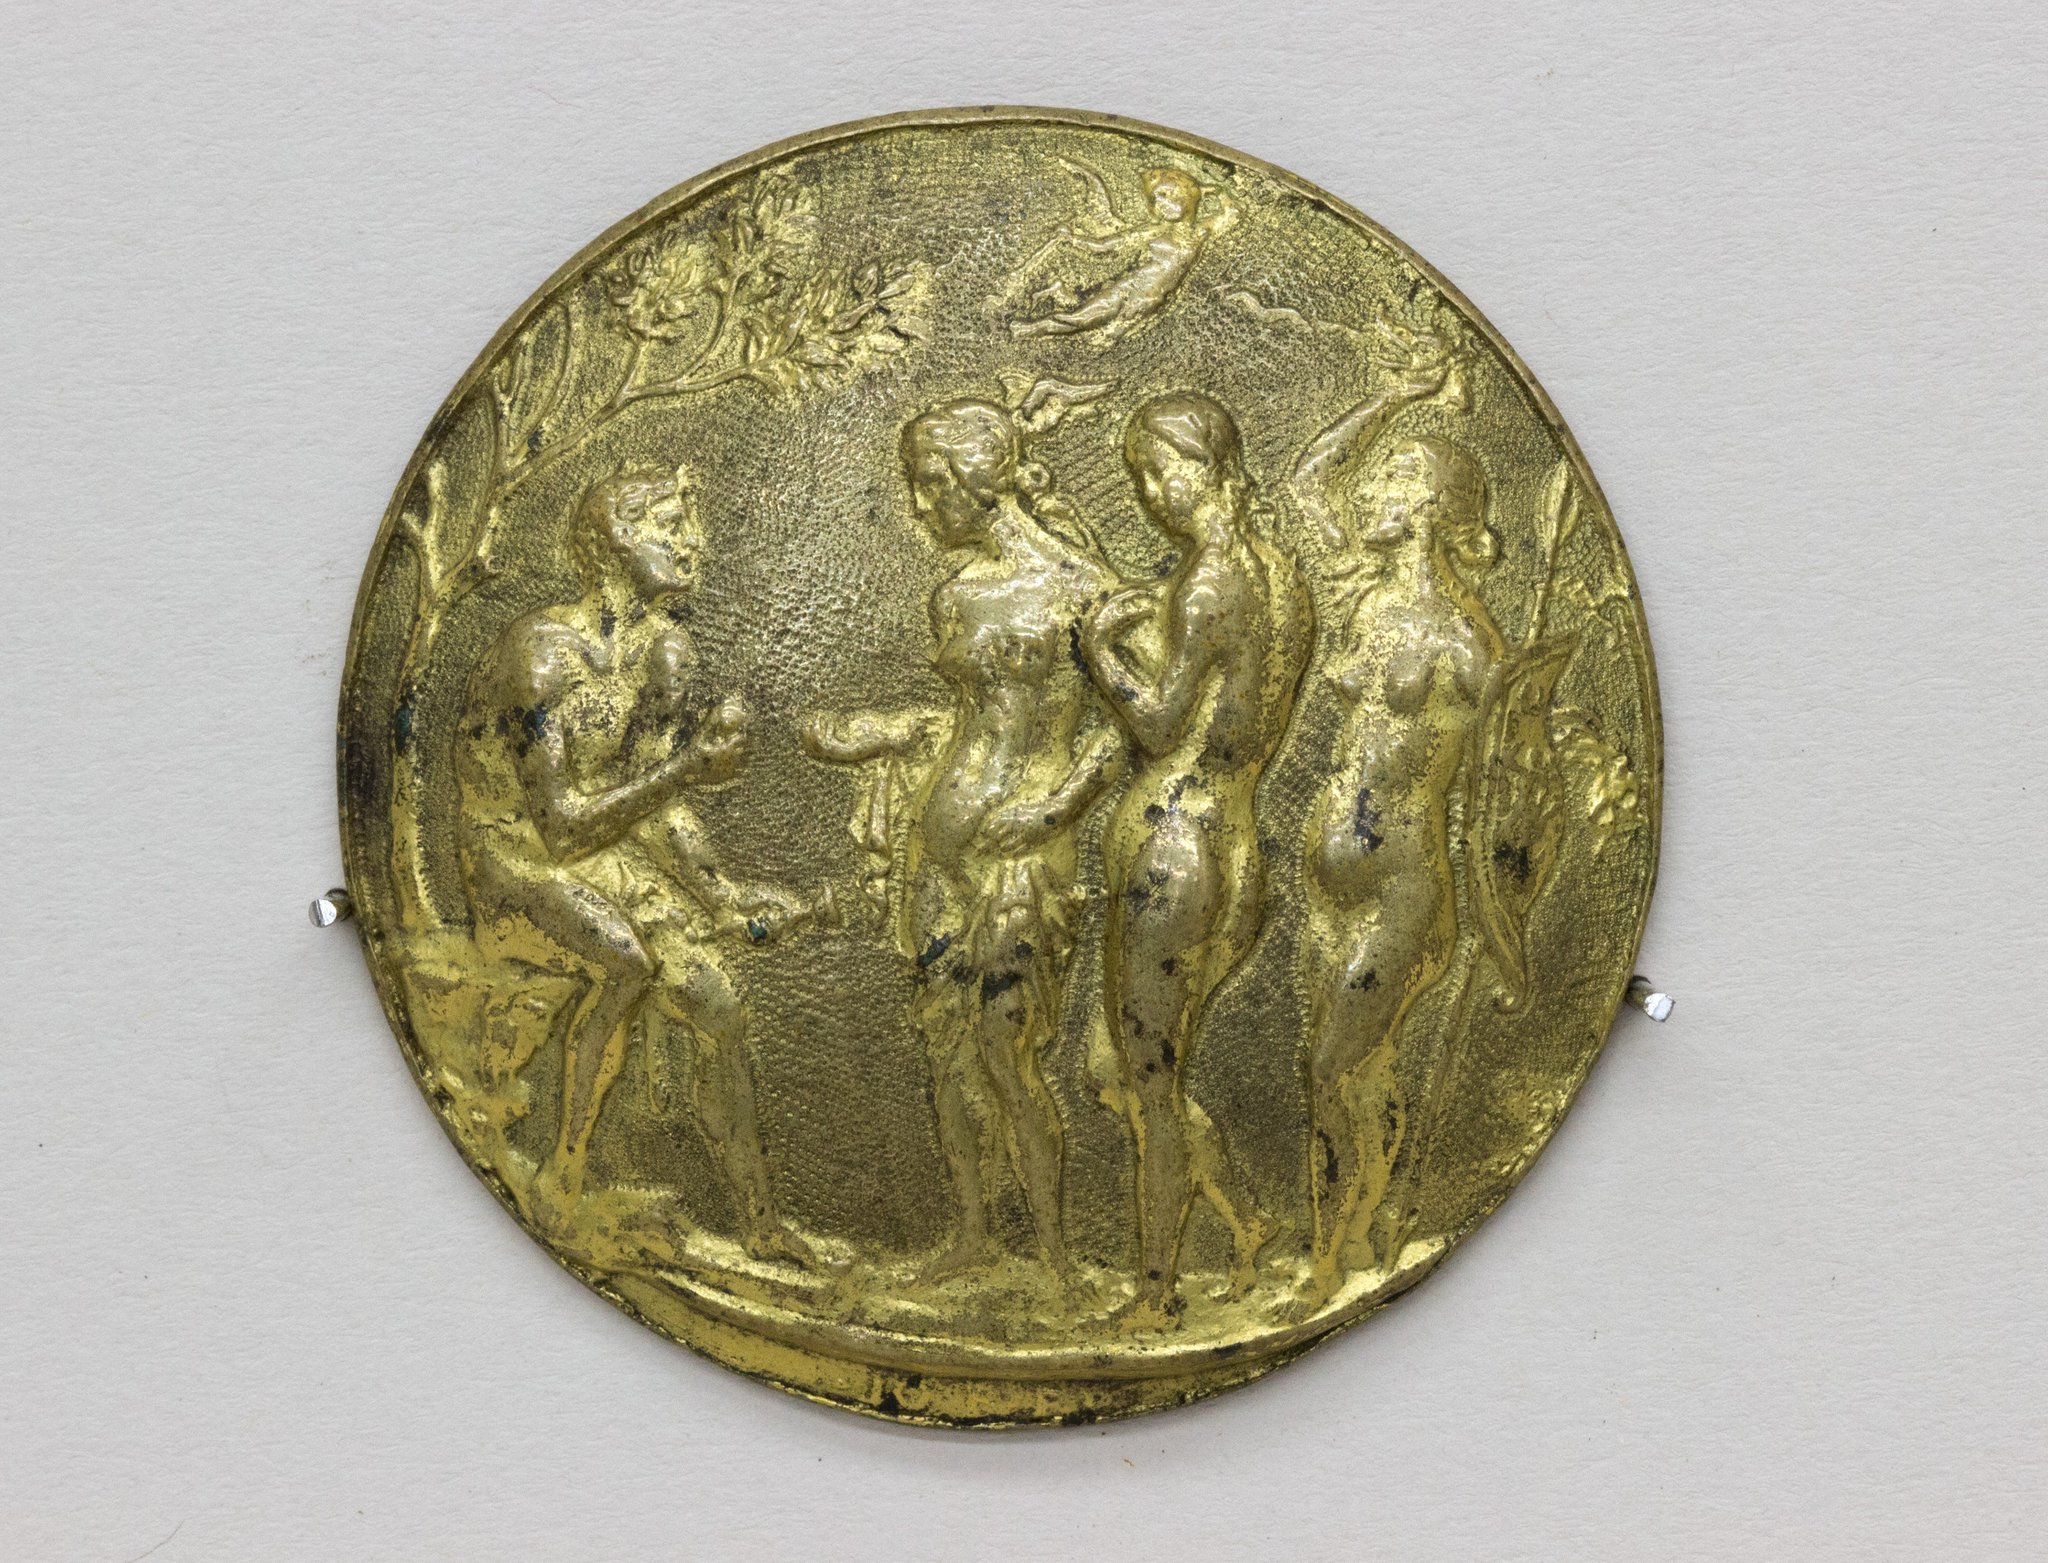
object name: sword pommel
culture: italian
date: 1501-1600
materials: bronze, gold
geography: italy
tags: female nudes,plants